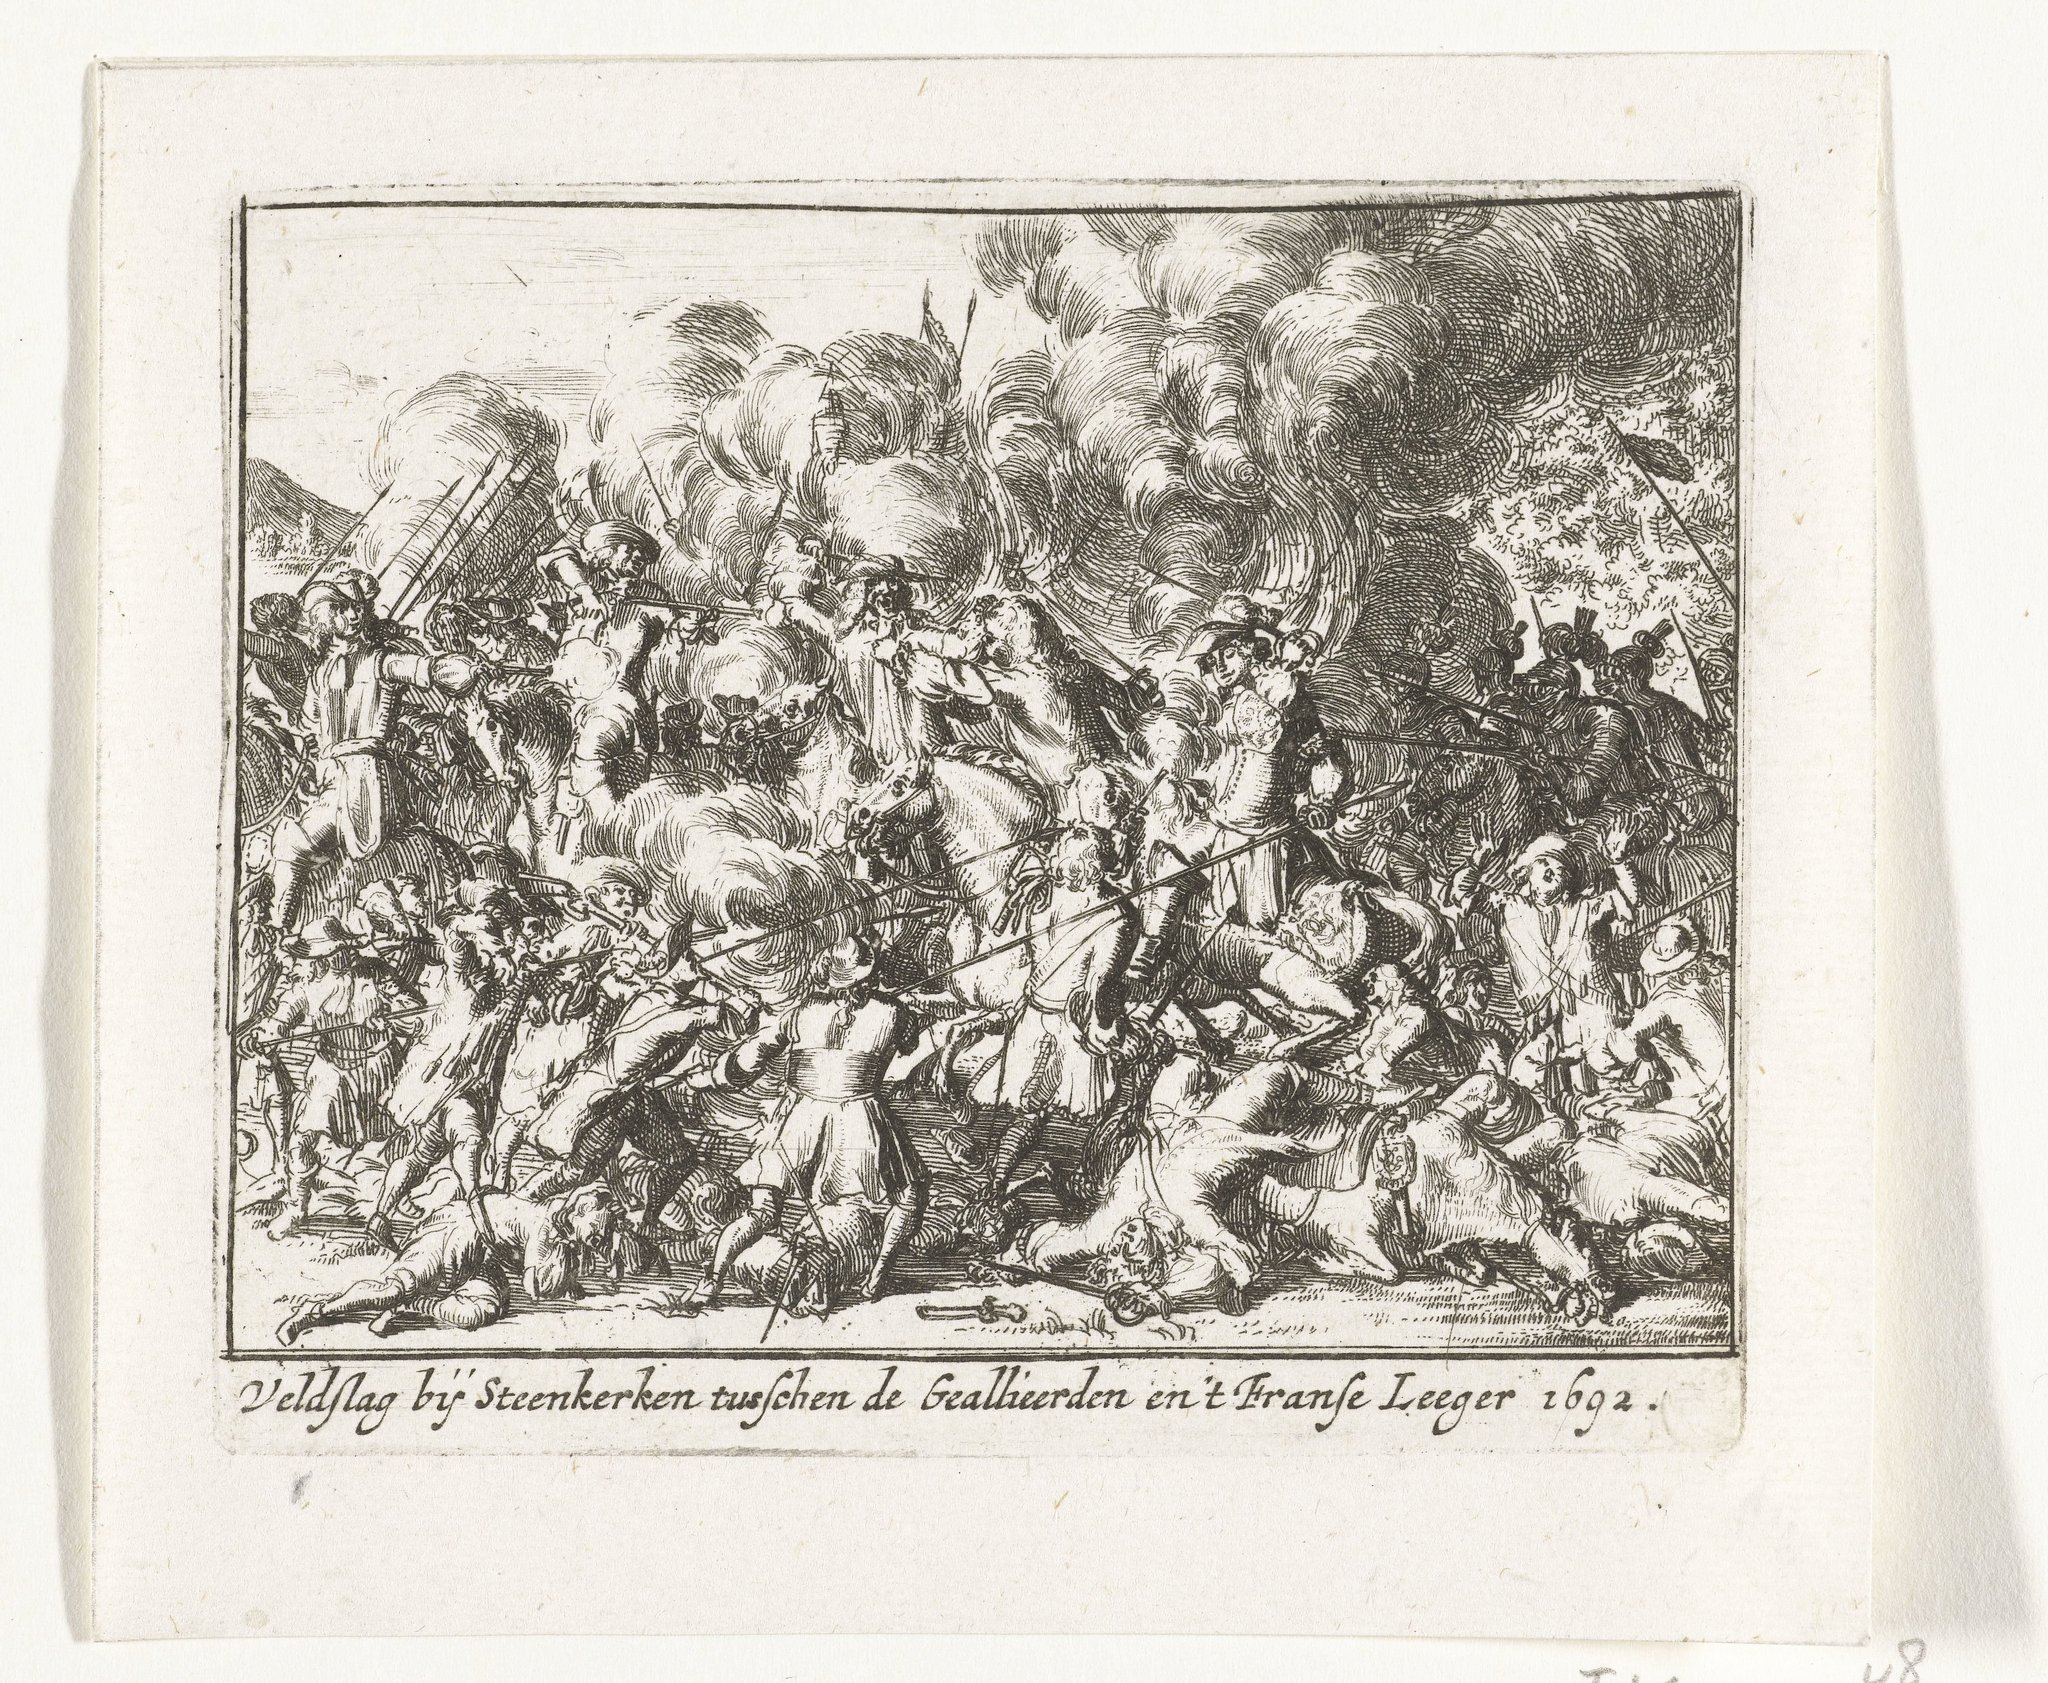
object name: history print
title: Slag bij Steenkerke, 1692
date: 1711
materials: paper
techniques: etching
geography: northern netherlands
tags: battle (+ land forces)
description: Veldslag bij Steenkerke tussen de geallieerden onder Willem III en het Franse leger onder Luxembourg, 3 augustus 1692. Onderdeel van een serie over de lotgevallen van het Engelse koningshuis van Stuart van 1558-1711, waarvan hier zijn opgenomen zestien prenten over de strijd tussen Jacobus II en Willem III in de jaren 1688-1689.